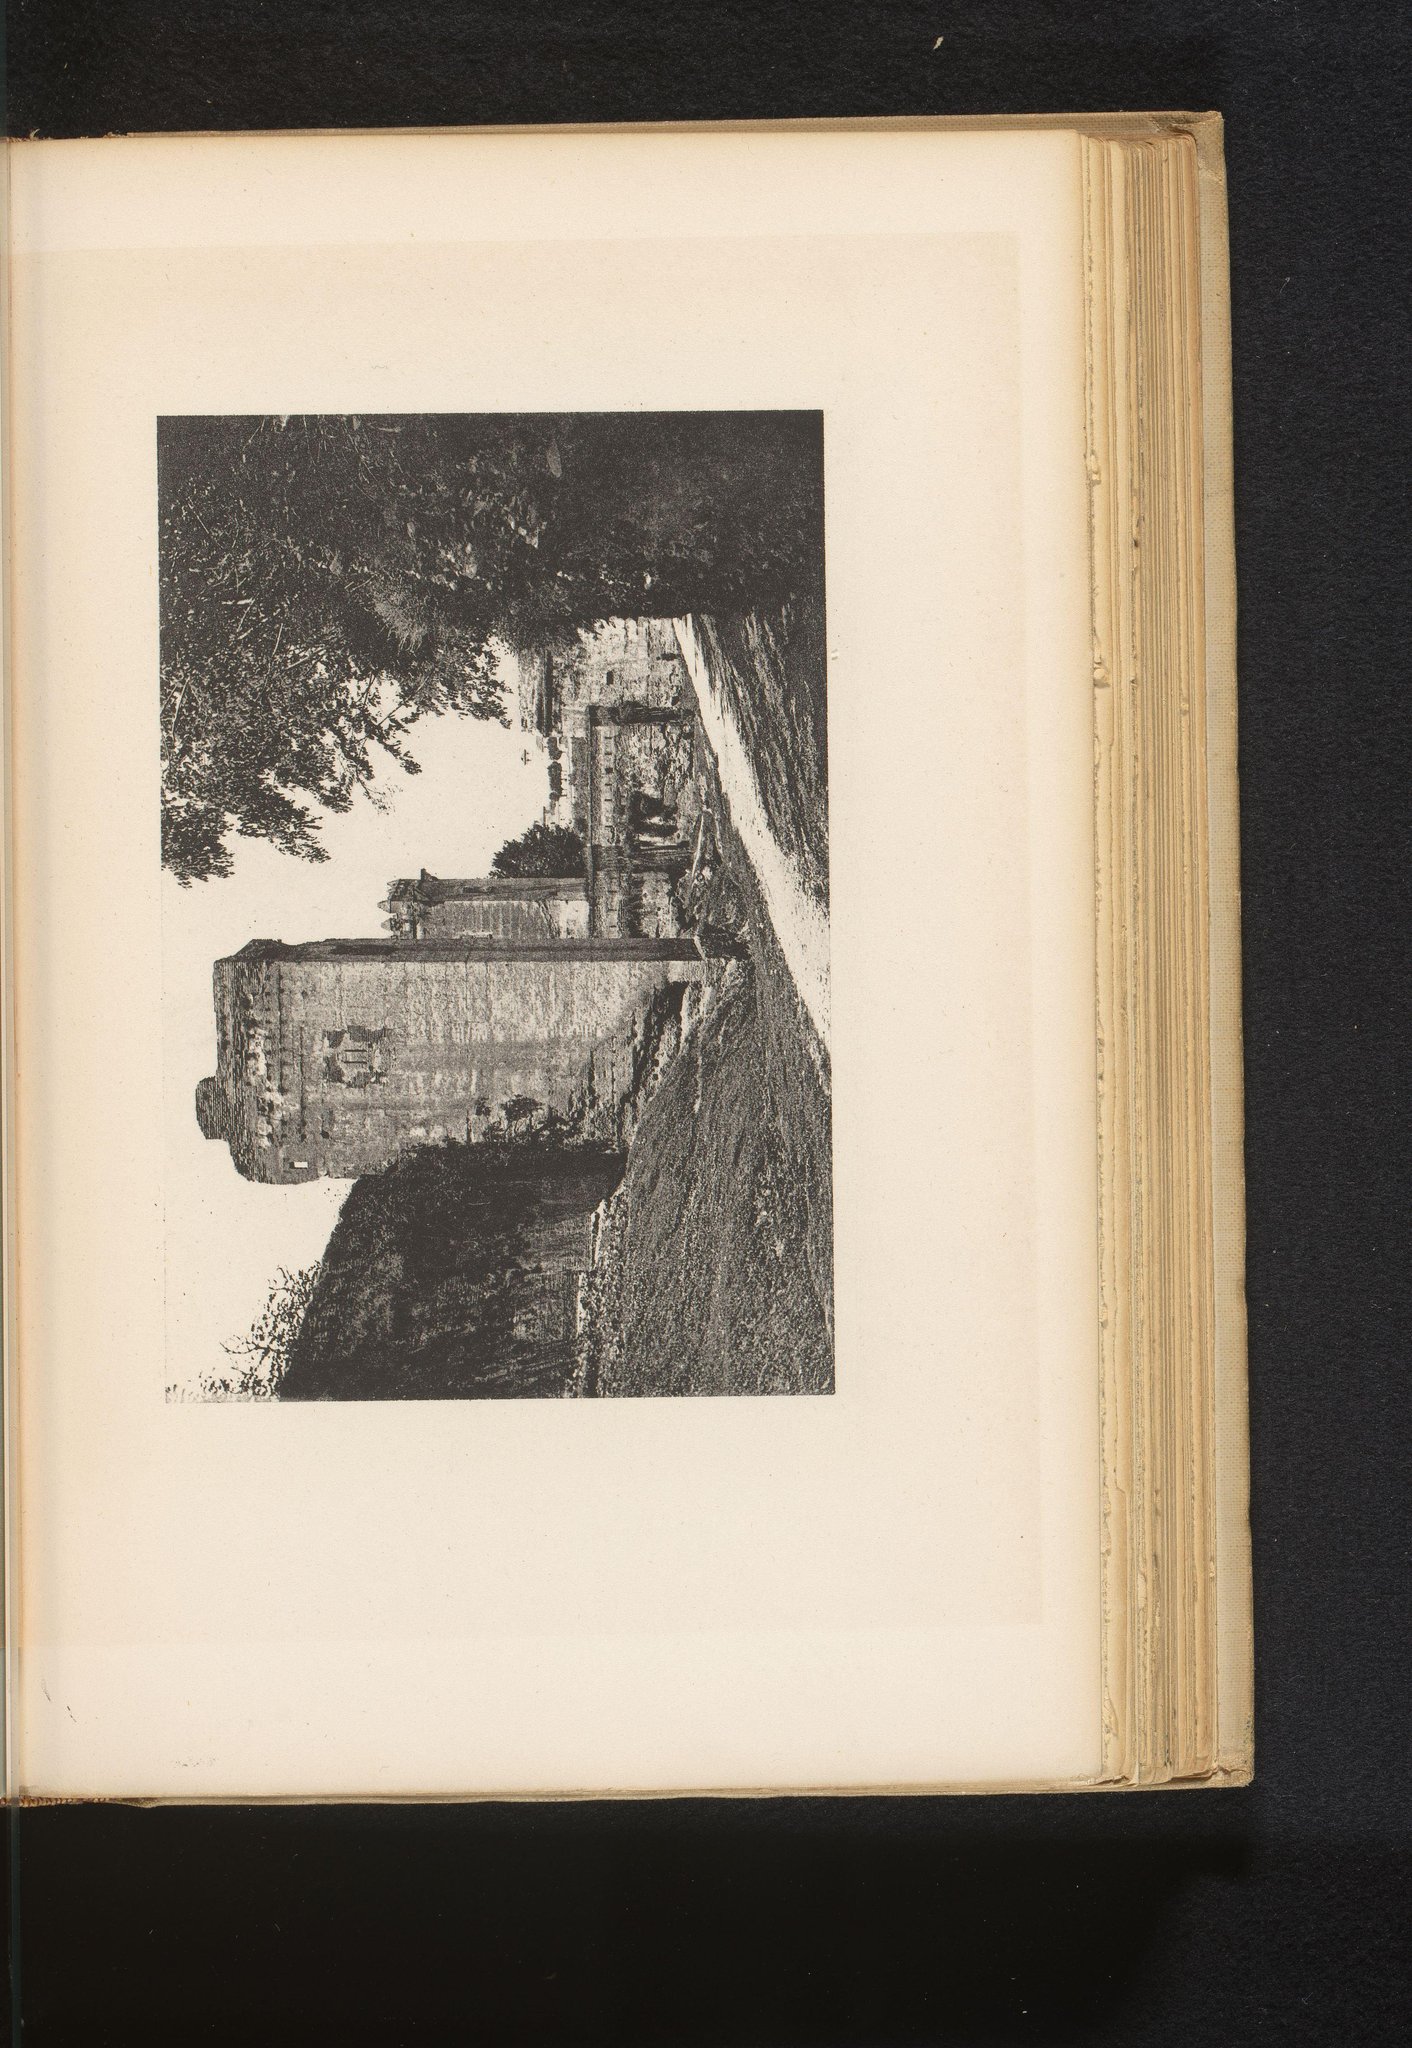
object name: page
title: Gezicht op de Torre del Cadí en de Torre de los Picos in het Alhambra in Granada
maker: Anonymous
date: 1884-1894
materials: paper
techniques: photoaquatint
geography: alhambra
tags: tower, clock tower ~ monumental adornment